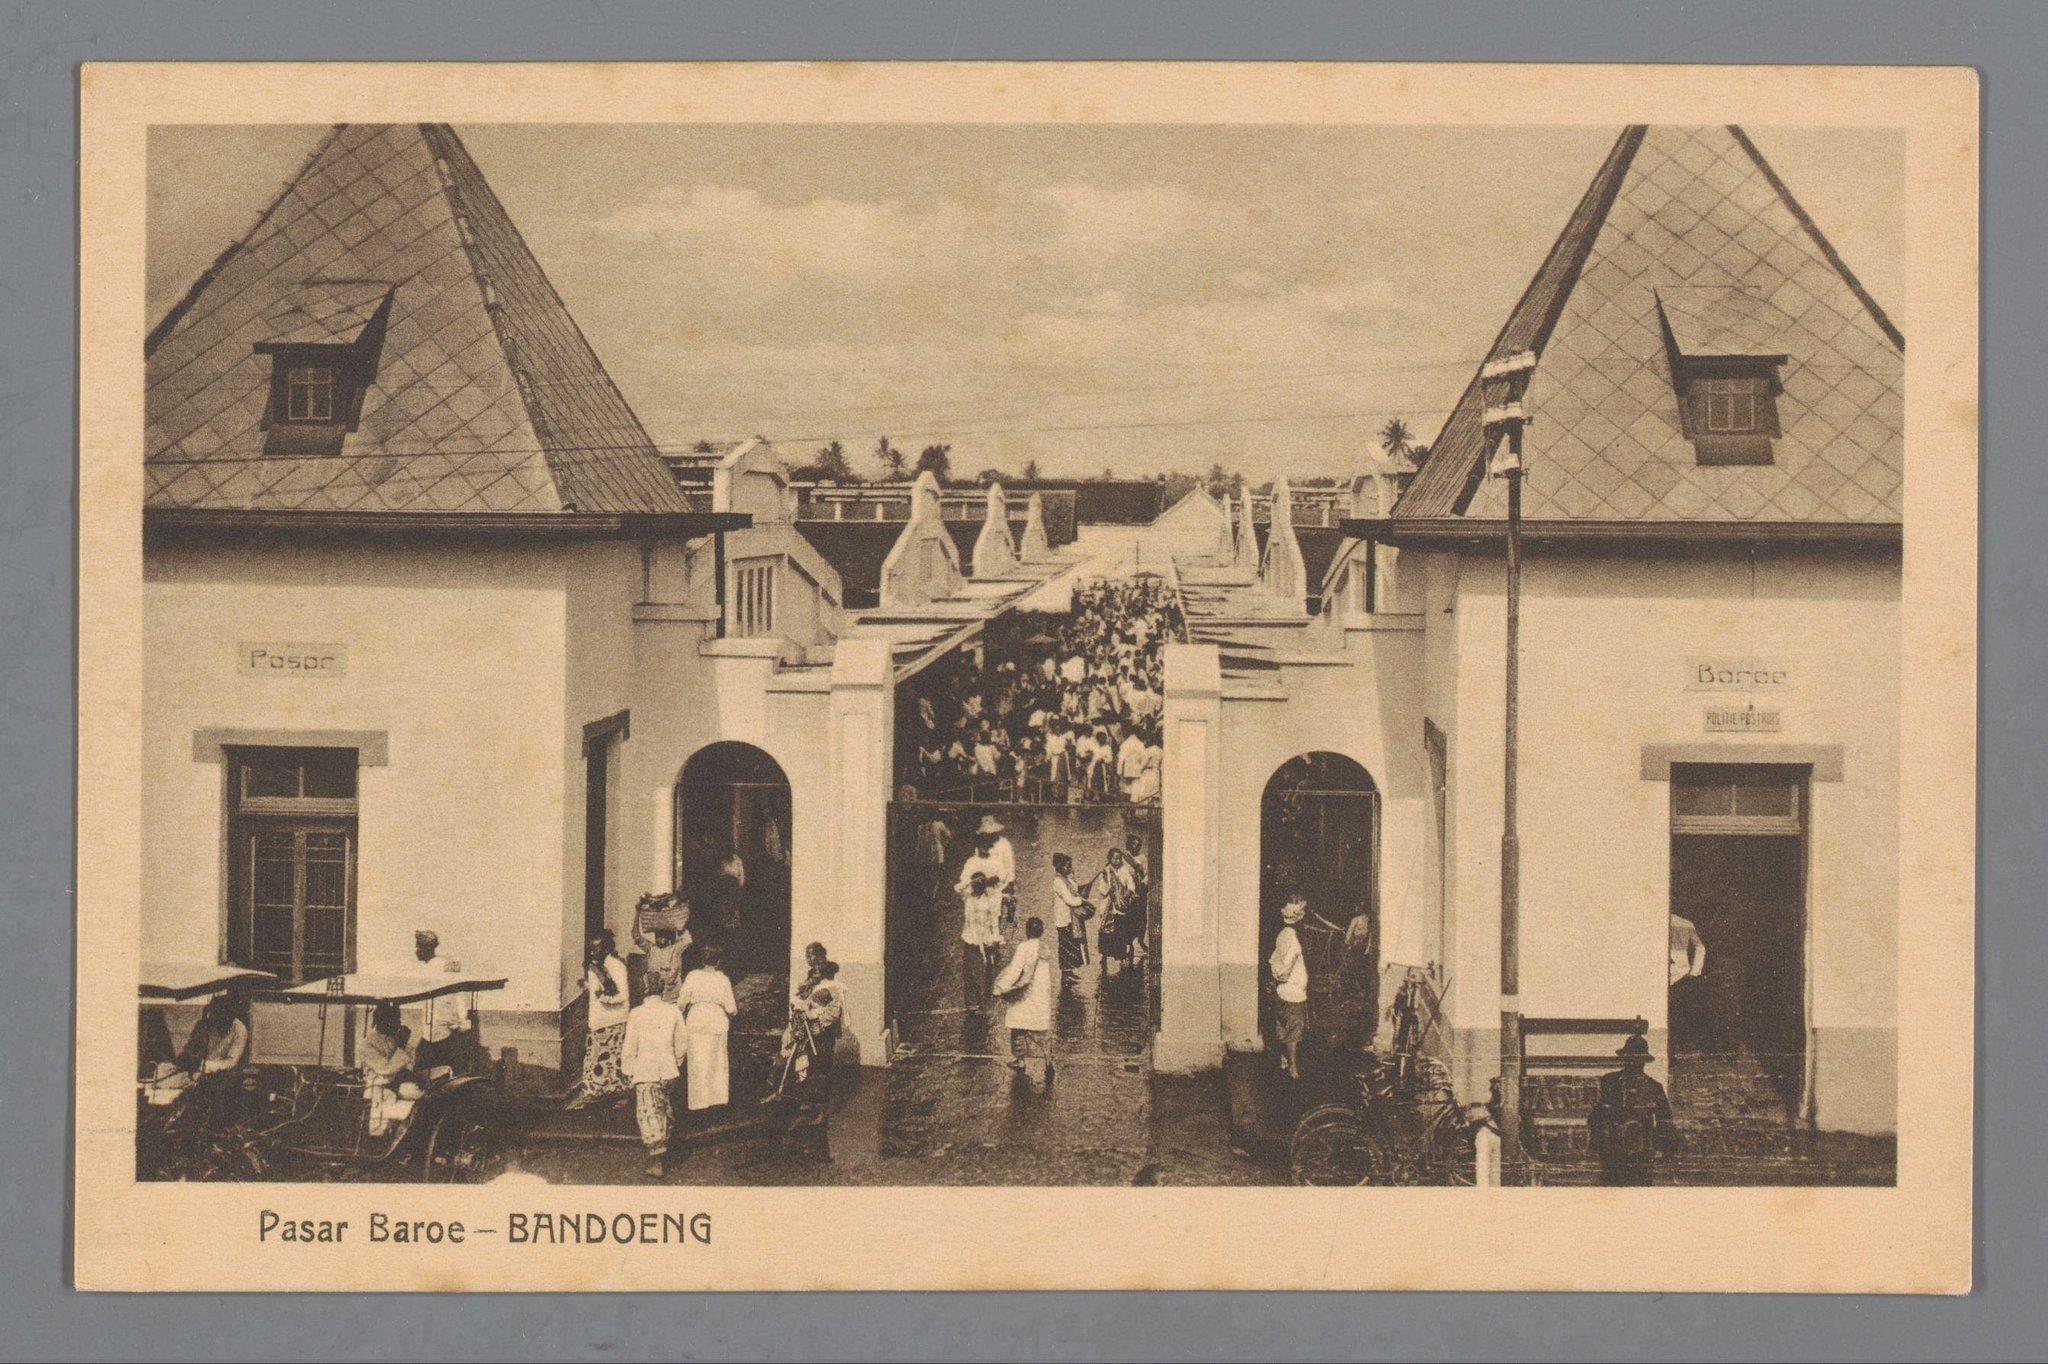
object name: postcard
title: Pasar Baroe-Bandoeng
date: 1900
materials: paper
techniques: photography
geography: bandung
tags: market, public road, dutch east indies, the, batavia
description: Eén van drie briefkaarten, onbeschreven, foto's van delen en gebouwen van Bandoeng (Java). Opschrift; achterzijde, m.b.: "Briefkaart". Opmerking: zie NG-1010-A t/m C.